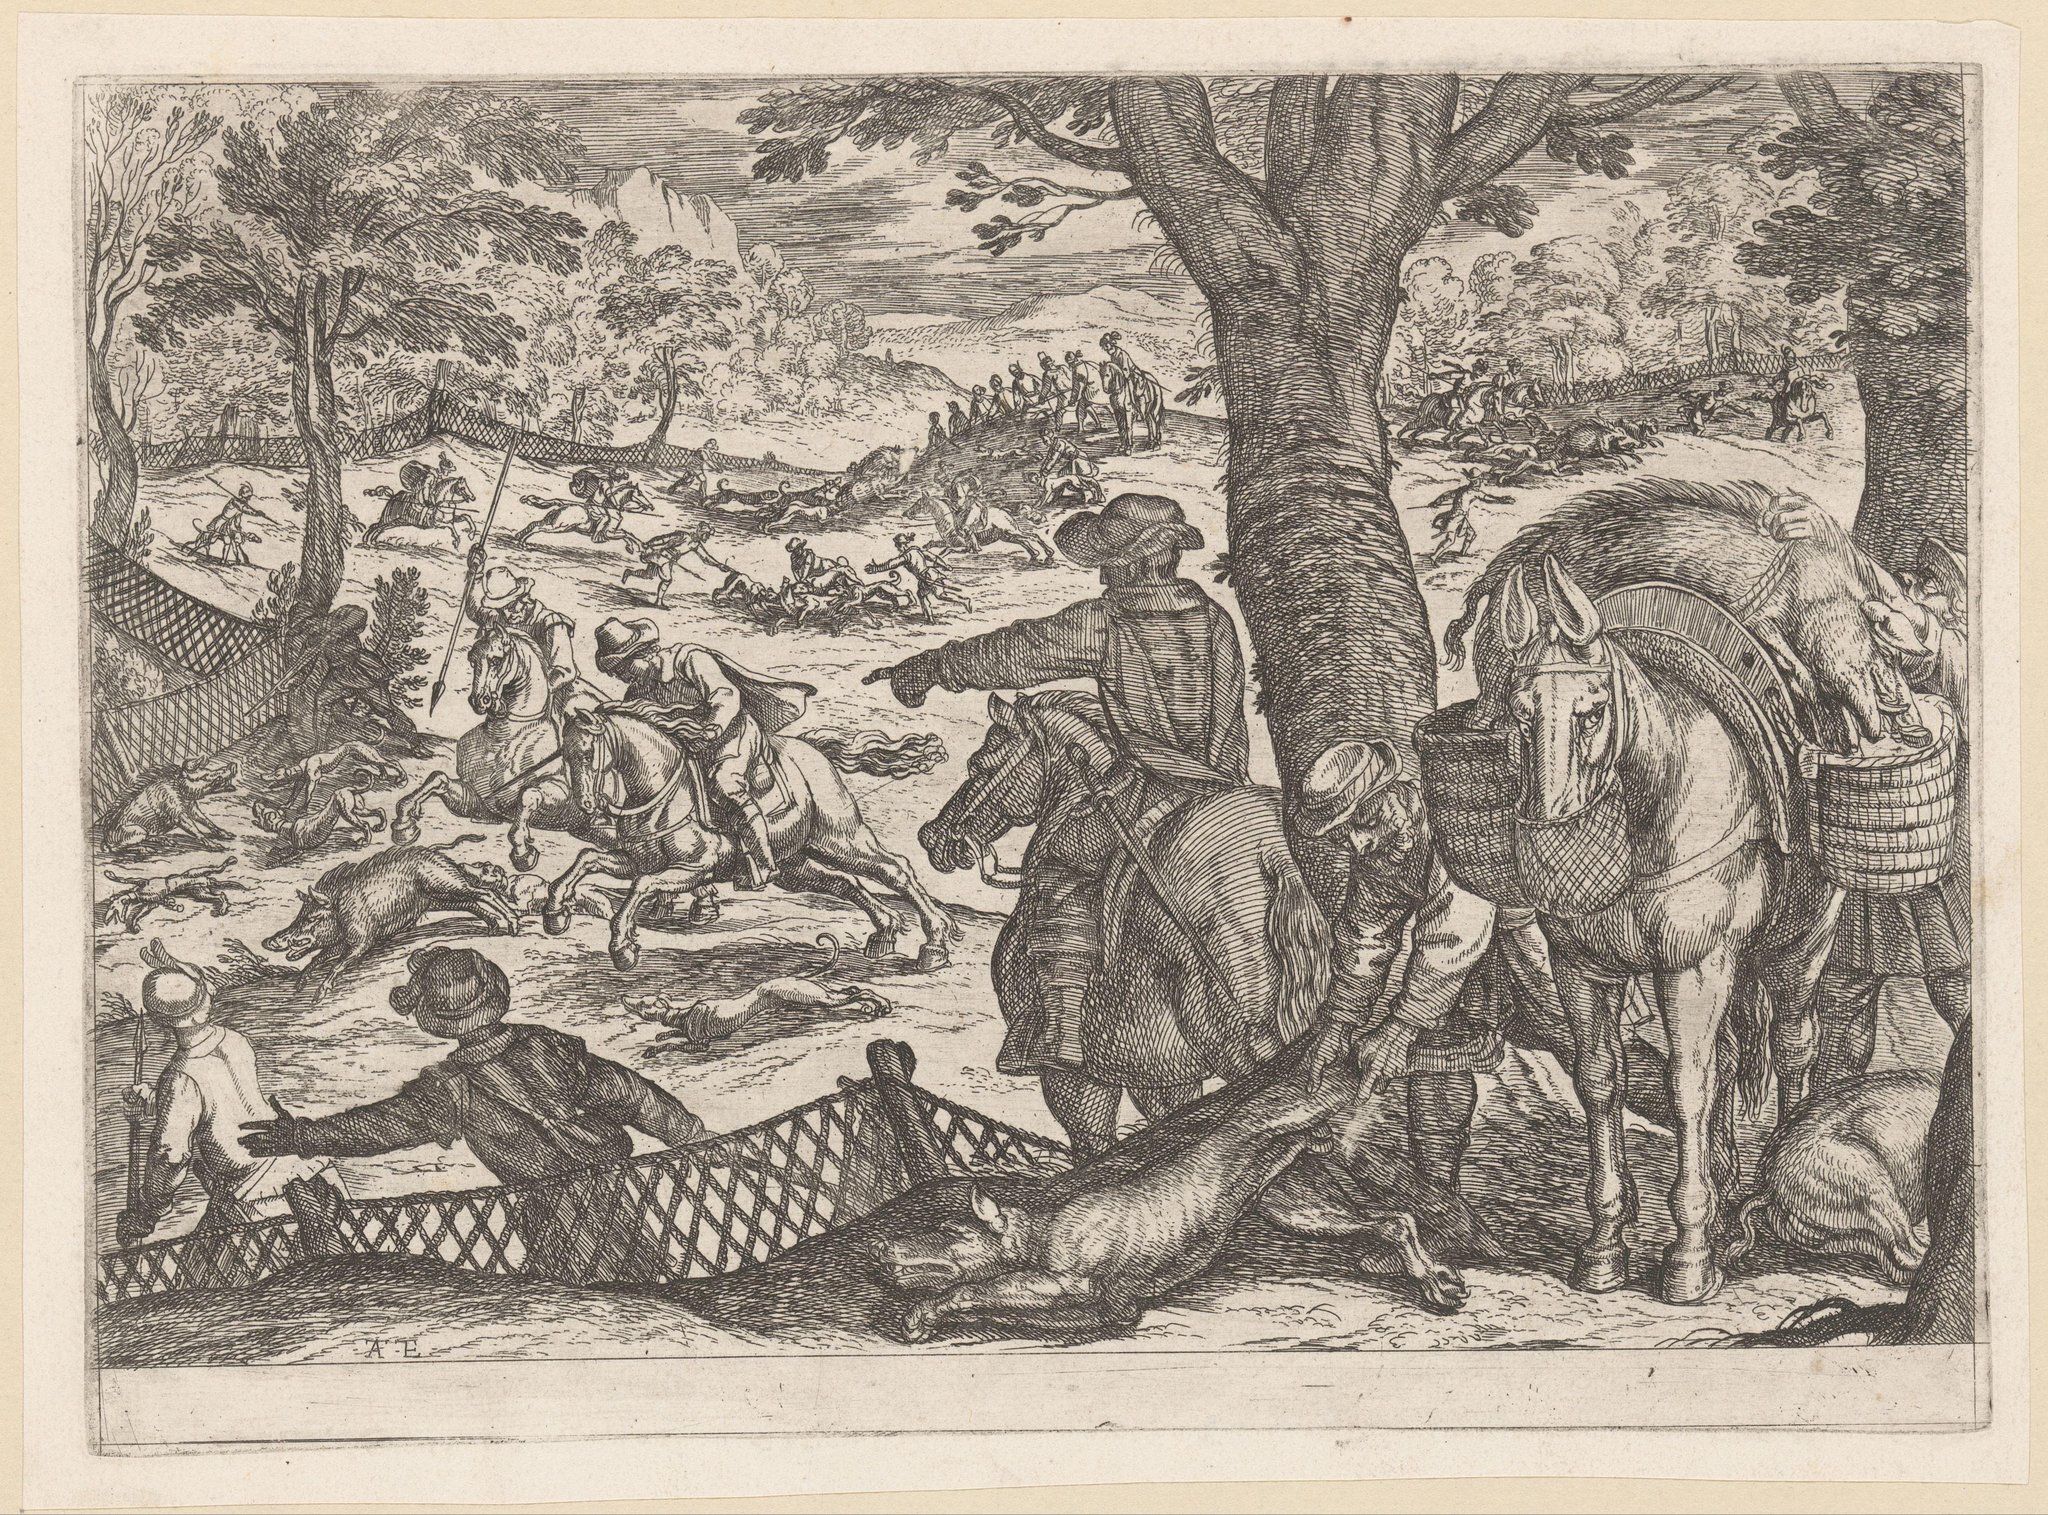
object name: print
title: Jachtscènes (deel 7)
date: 1608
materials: paper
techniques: etching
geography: rome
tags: boar-hunting, hunter, hunters hunting (n.b.: in 1988-1990 this notation denoted the concept of 43c11421 'hunters resting during the hunt')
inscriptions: collector's mark: Lugt 240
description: Landschap met jagers die met behulp van netten en jachthonden everzwijnen proberen te vangen.